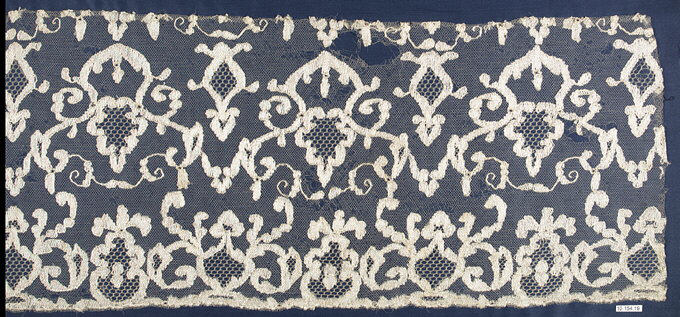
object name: flounce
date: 1801-1900